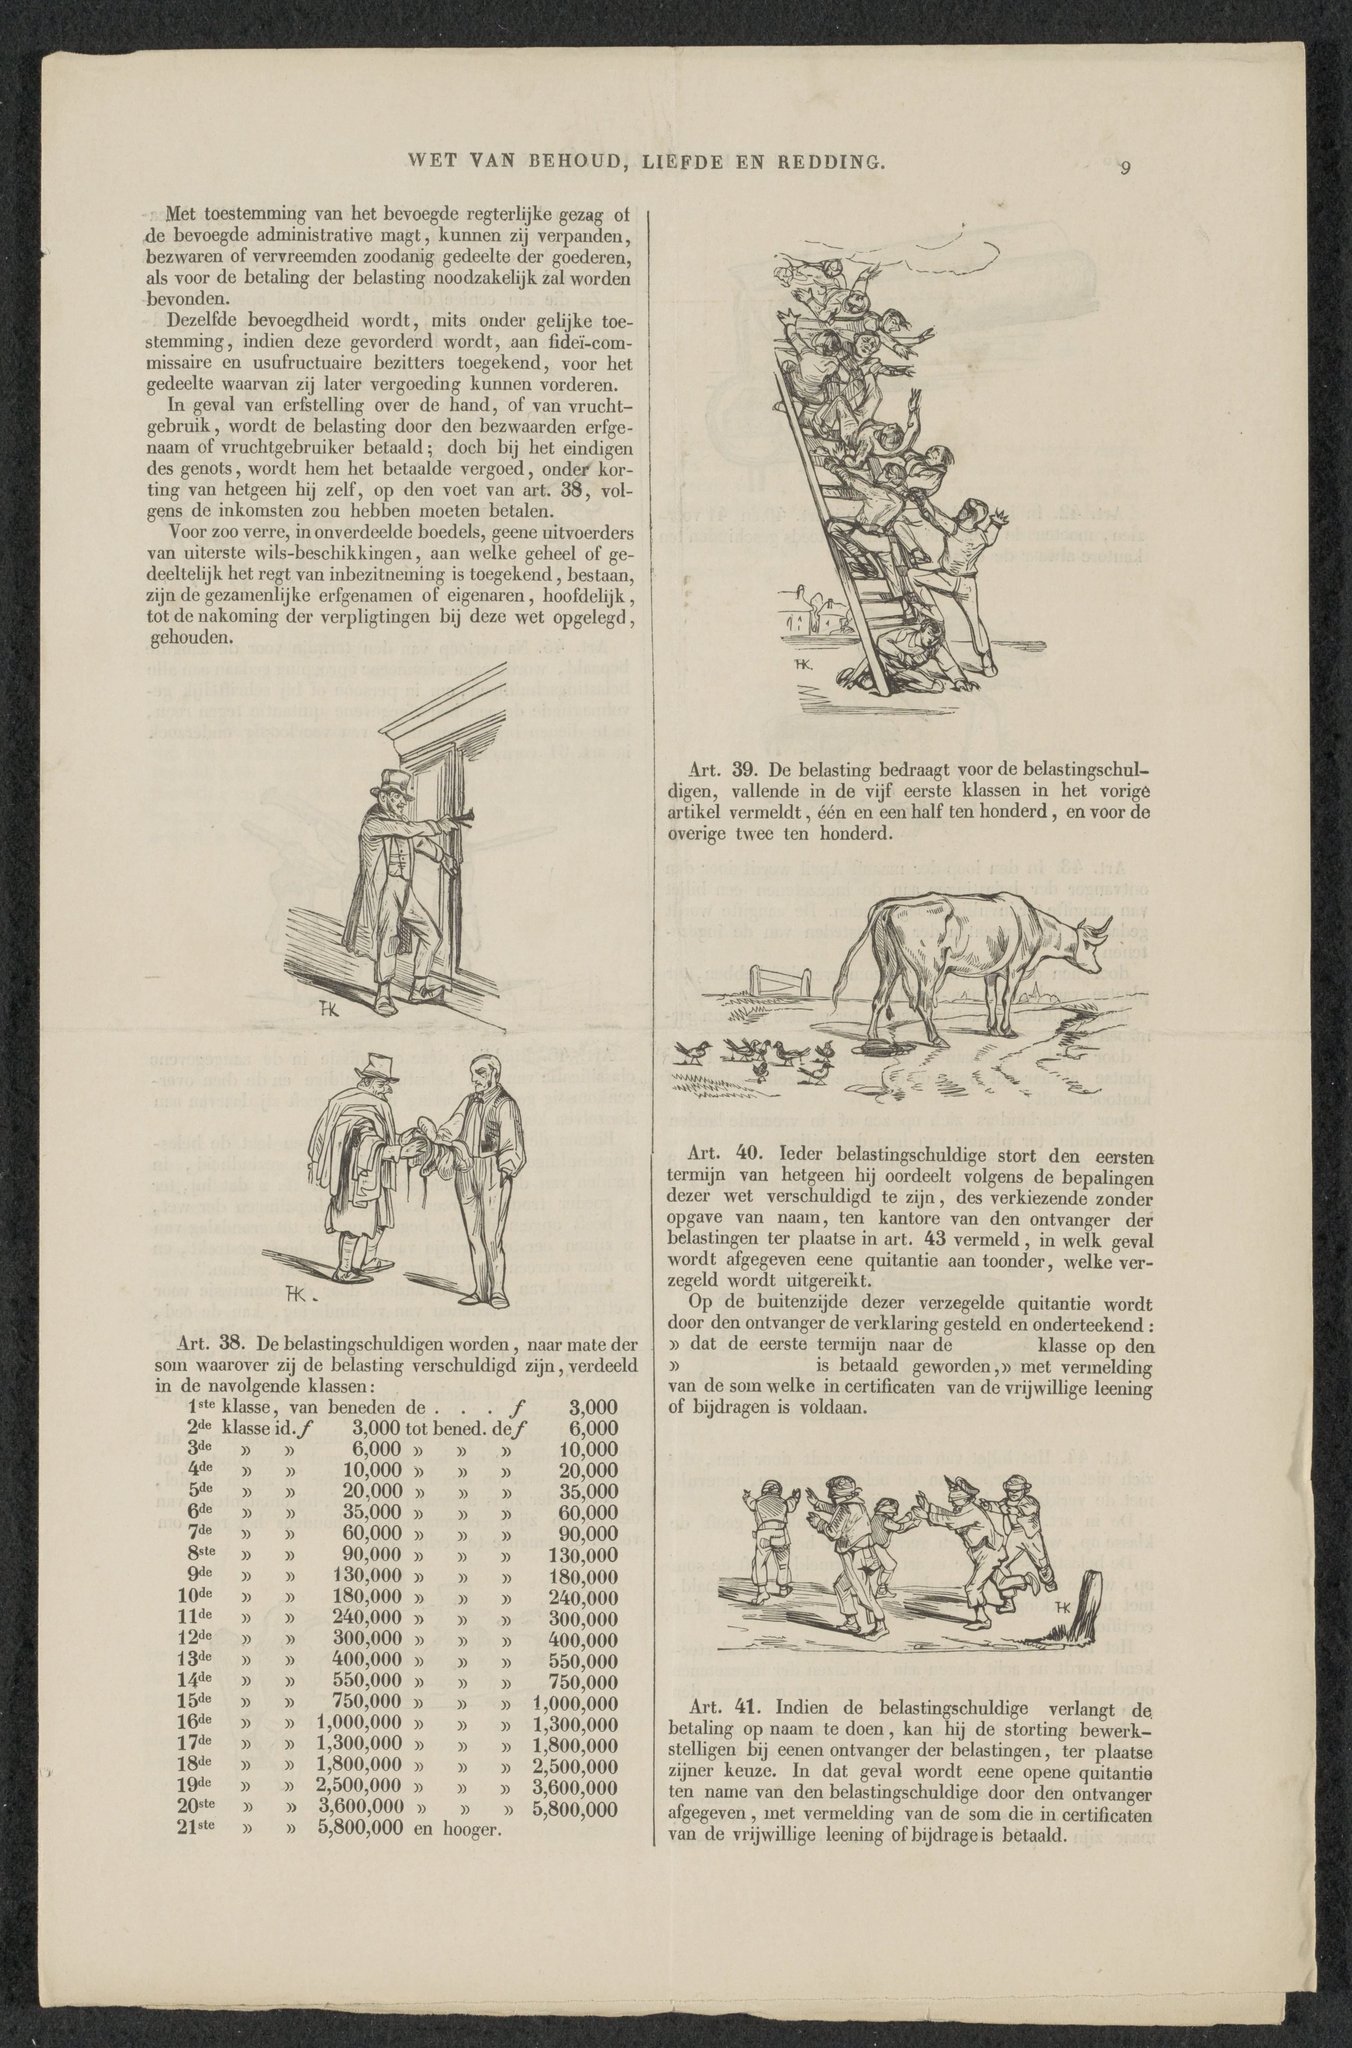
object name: print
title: Satire op de aansporing tot deelneming in de (zogenaamde) vrijwillige 3% geldlening van 1844 (blad 9)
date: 1844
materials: paper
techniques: letterpress printing, engraving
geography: netherlands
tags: amsterdam, the hague, floris adriaan van hall, organization of trade and finance, taxes and financial administration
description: Bladzijde 9 met artikels 38-41 van de 'Wet van Behoud, Liefde en Redding'. Een satire in zestien bladzijden op de aansporing tot deelneming in de (zogenaamde) vrijwillige 3% geldlening uitgeschreven in maart 1844 door minister F.A. van Hall. Voorzijde van een dubbelgevouwen blad bedrukt op alle zijden.